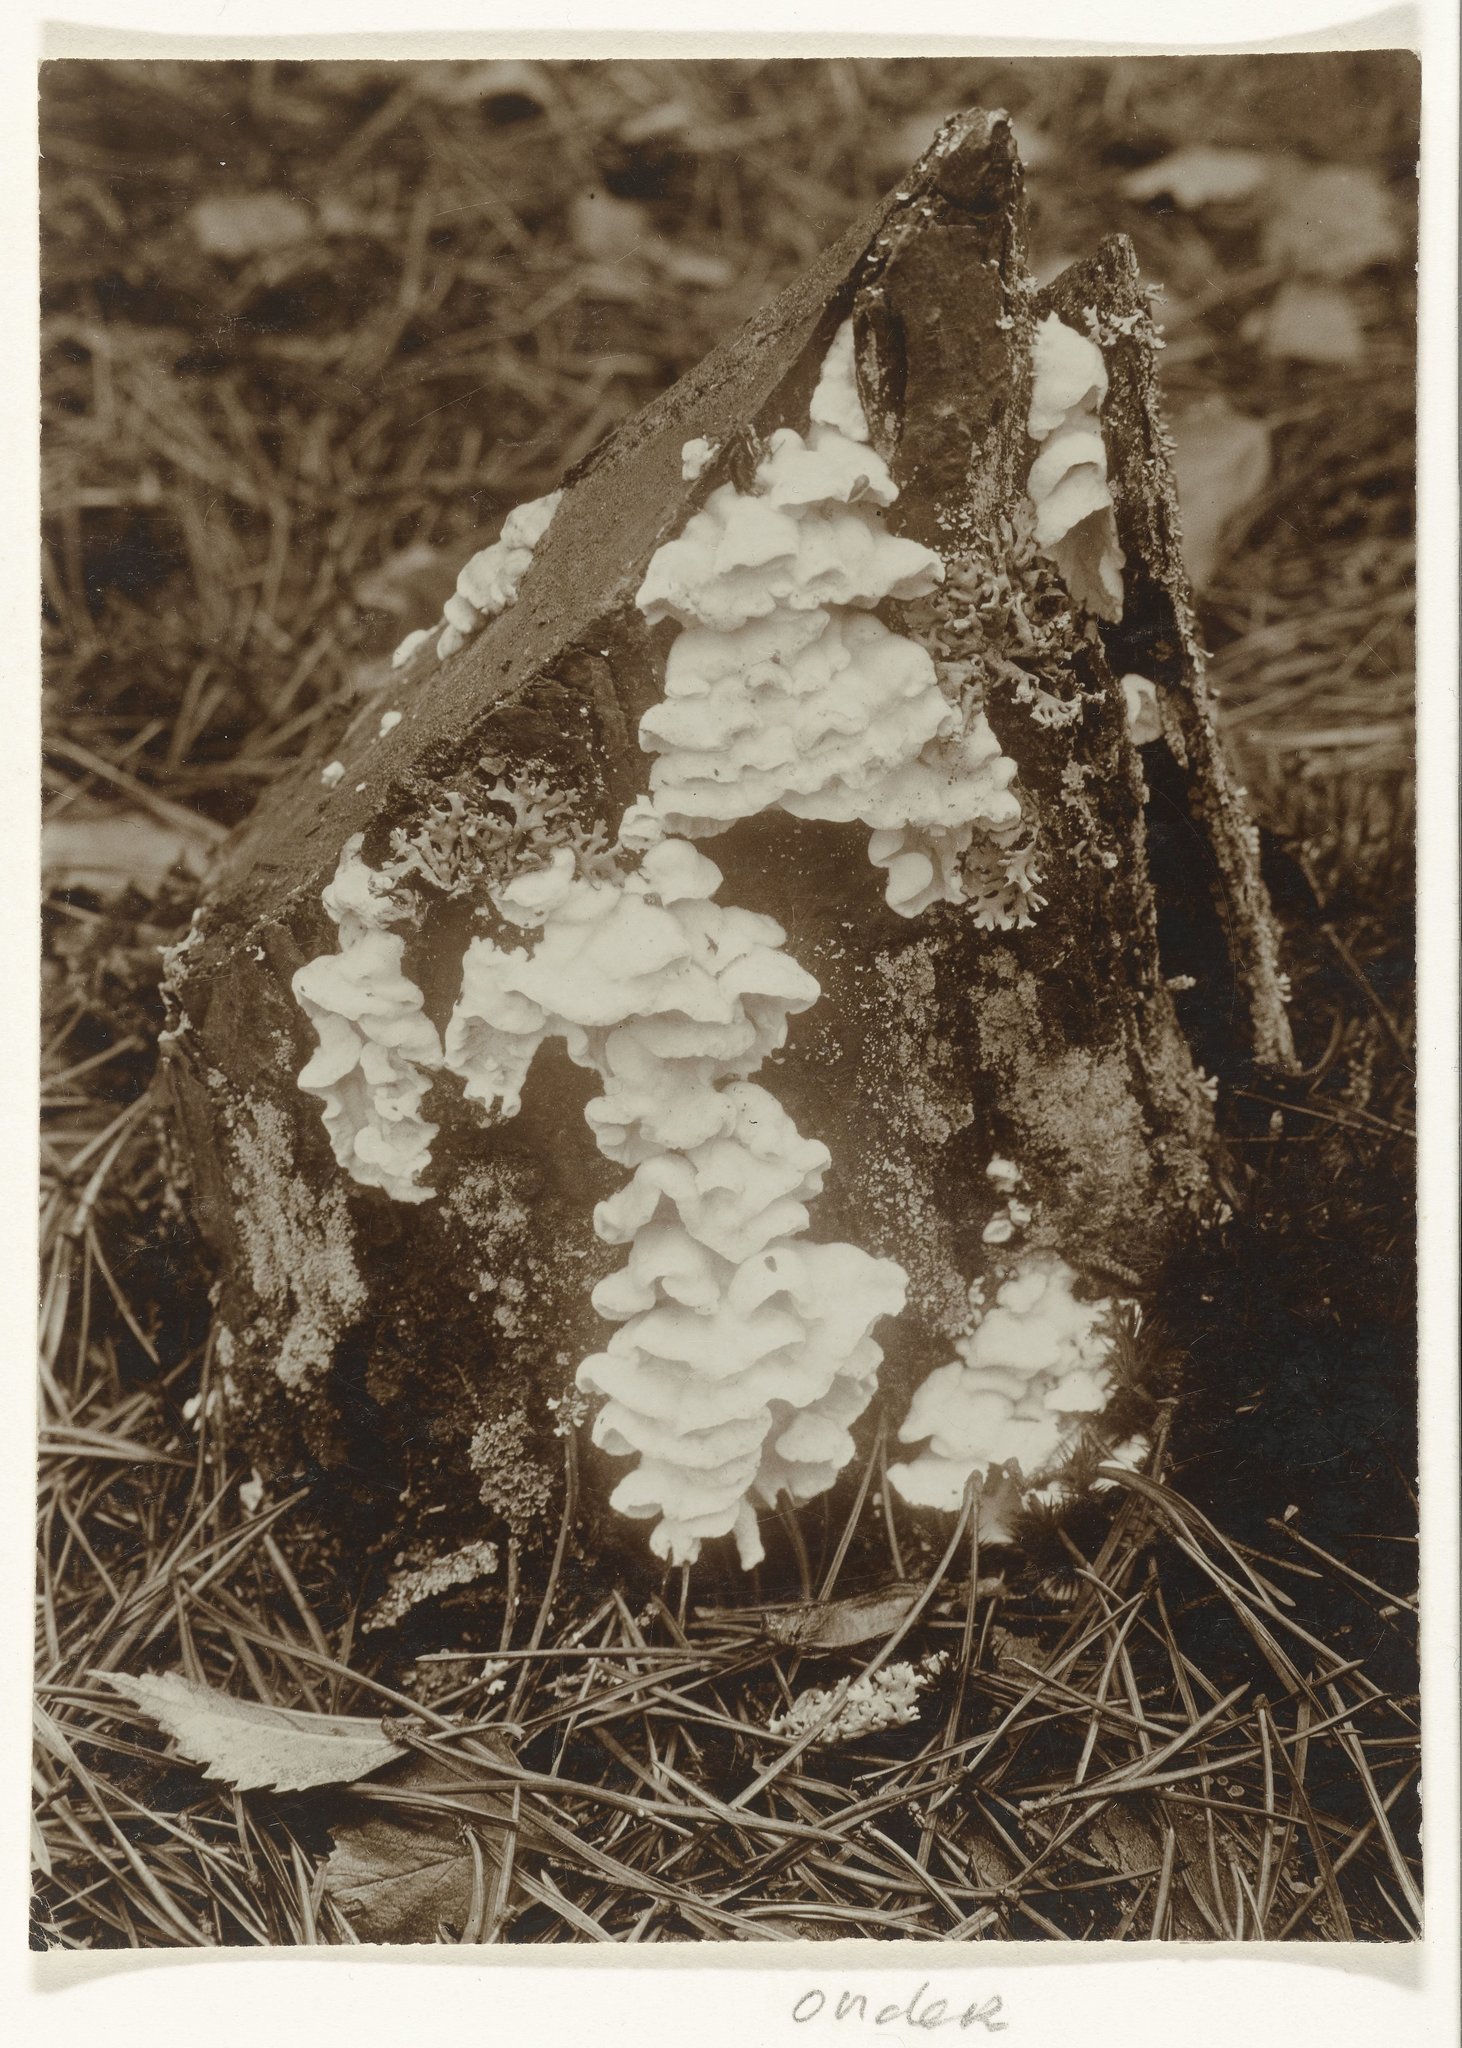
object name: photograph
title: Weisse Poria auf einem Kiefernstumpf Witte Poria Poria vaporaria op een dennenstomp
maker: richard tepe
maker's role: fotograaf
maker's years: 1864-1952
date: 1900-1930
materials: photographic support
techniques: gelatin silver print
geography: netherlands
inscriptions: annotation: ‘Weisse Poria / auf einem Kiefernstumpf / Witte Poria / Poria vaporaria / op een dennenstomp’, signature: ‘foto / R Tepe’